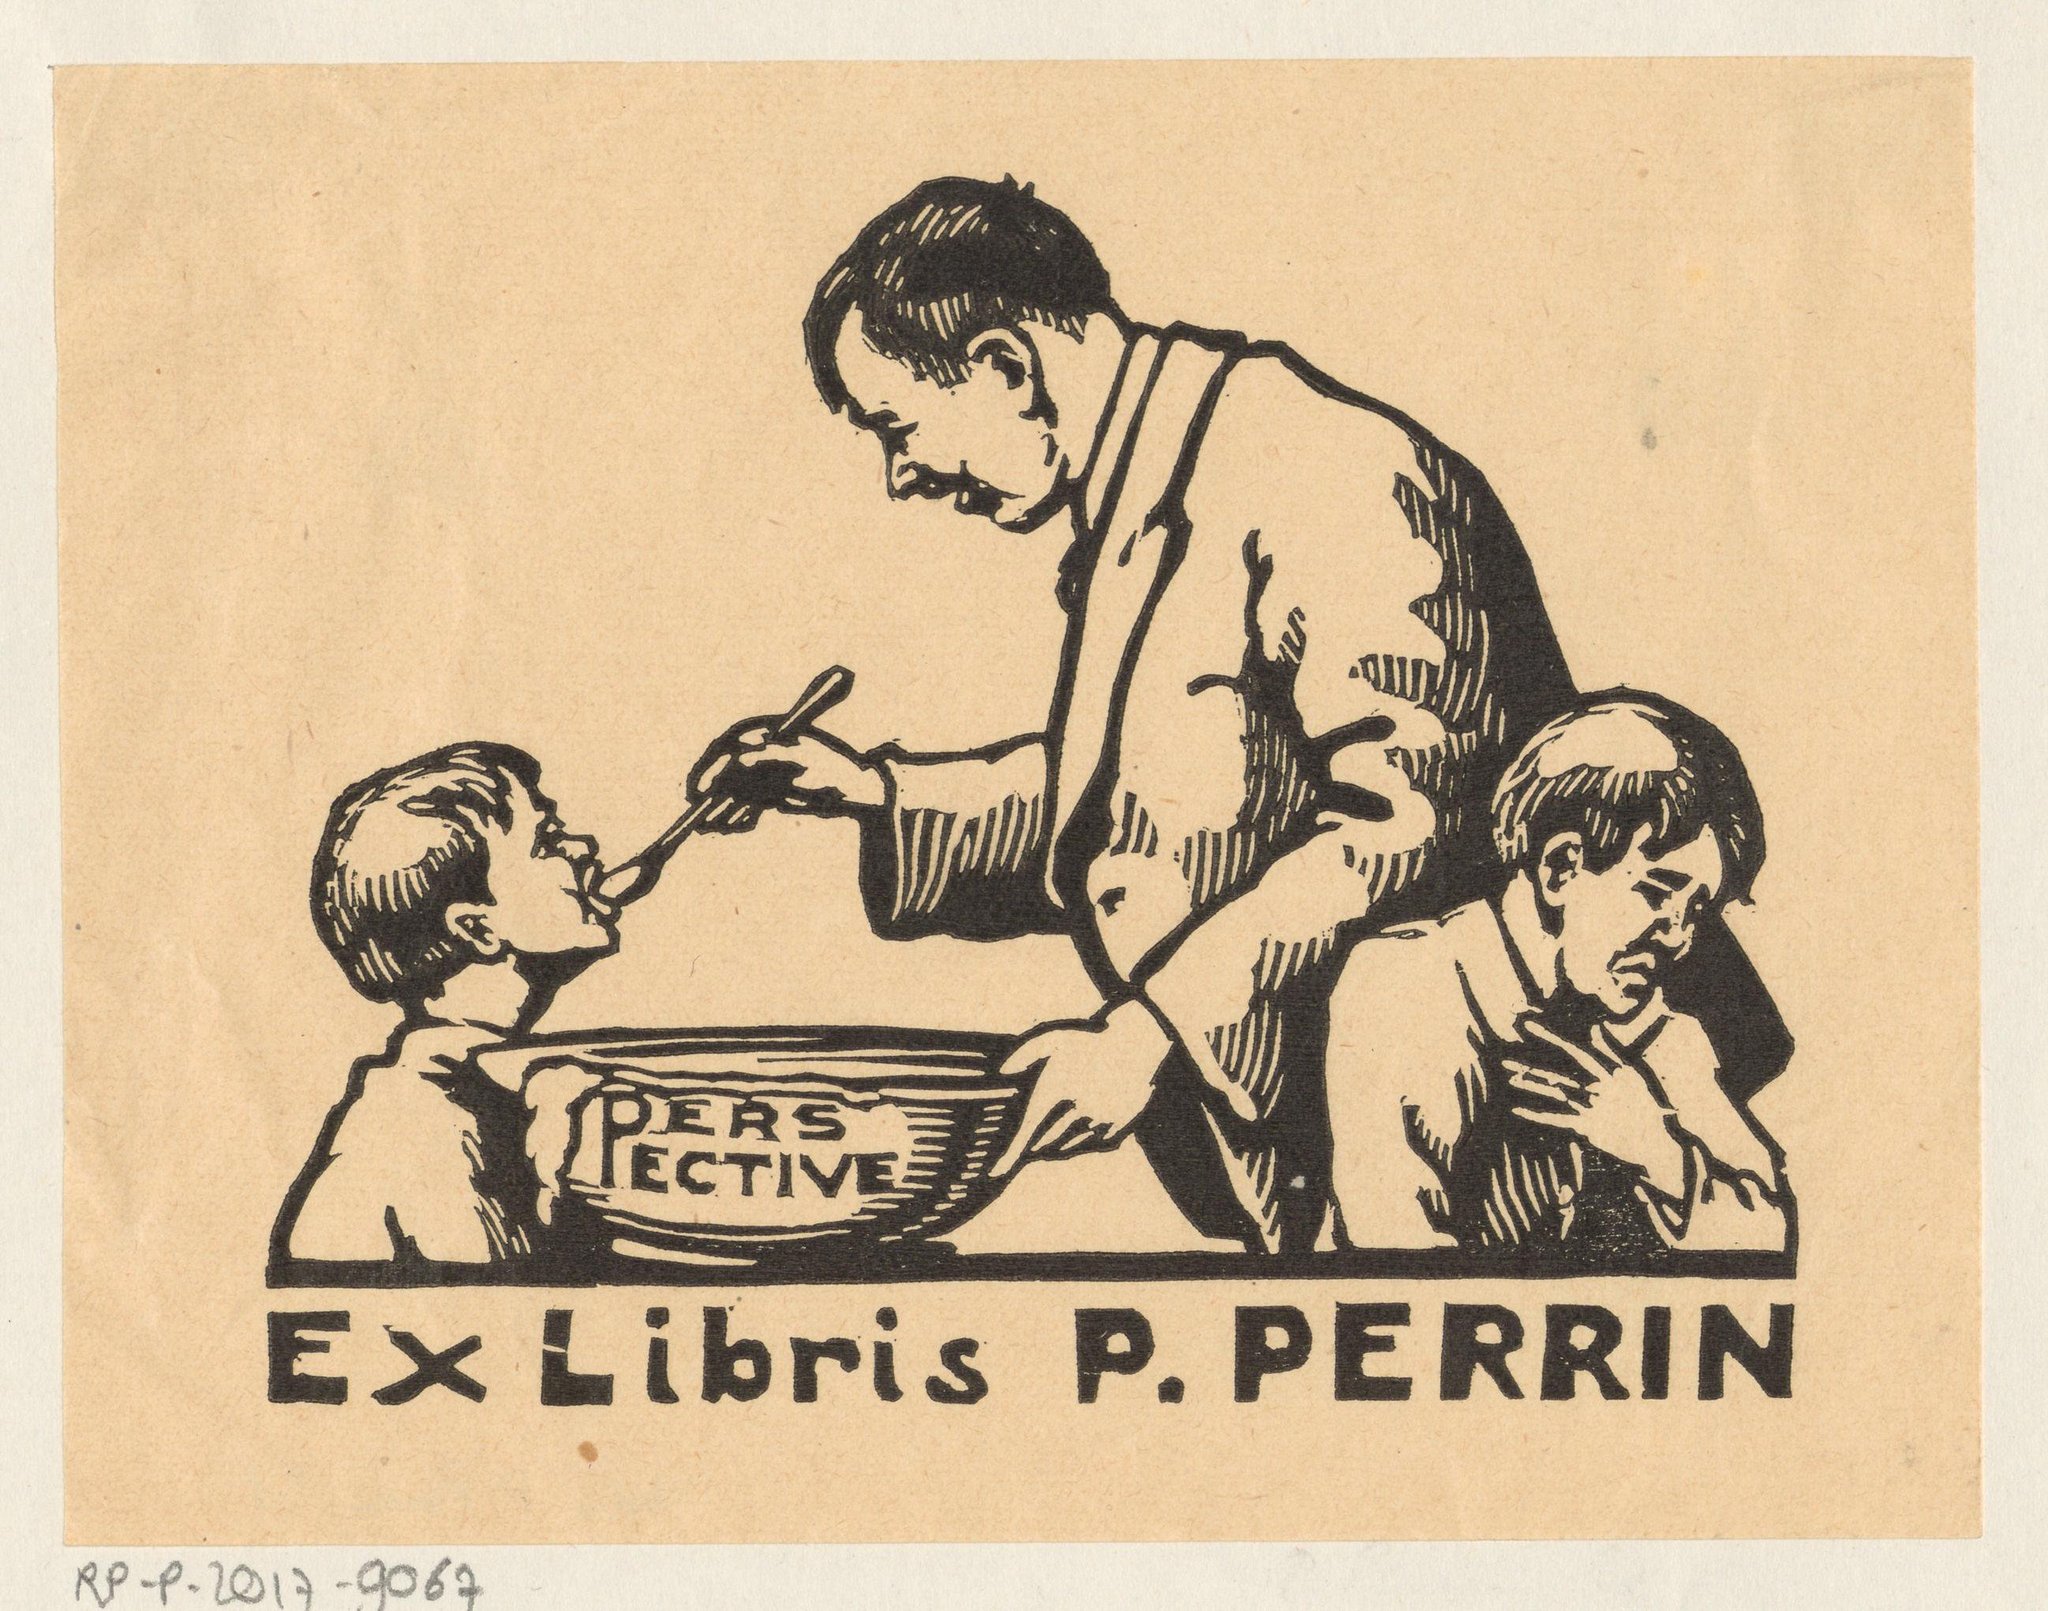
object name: bookplate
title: Perspective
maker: pierre perrin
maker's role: print maker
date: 1938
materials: paper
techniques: woodcut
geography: france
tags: pierre perrin, giving food, boy (child between toddler and youth)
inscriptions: inscription: ‘bois Pierre Perrin '38’